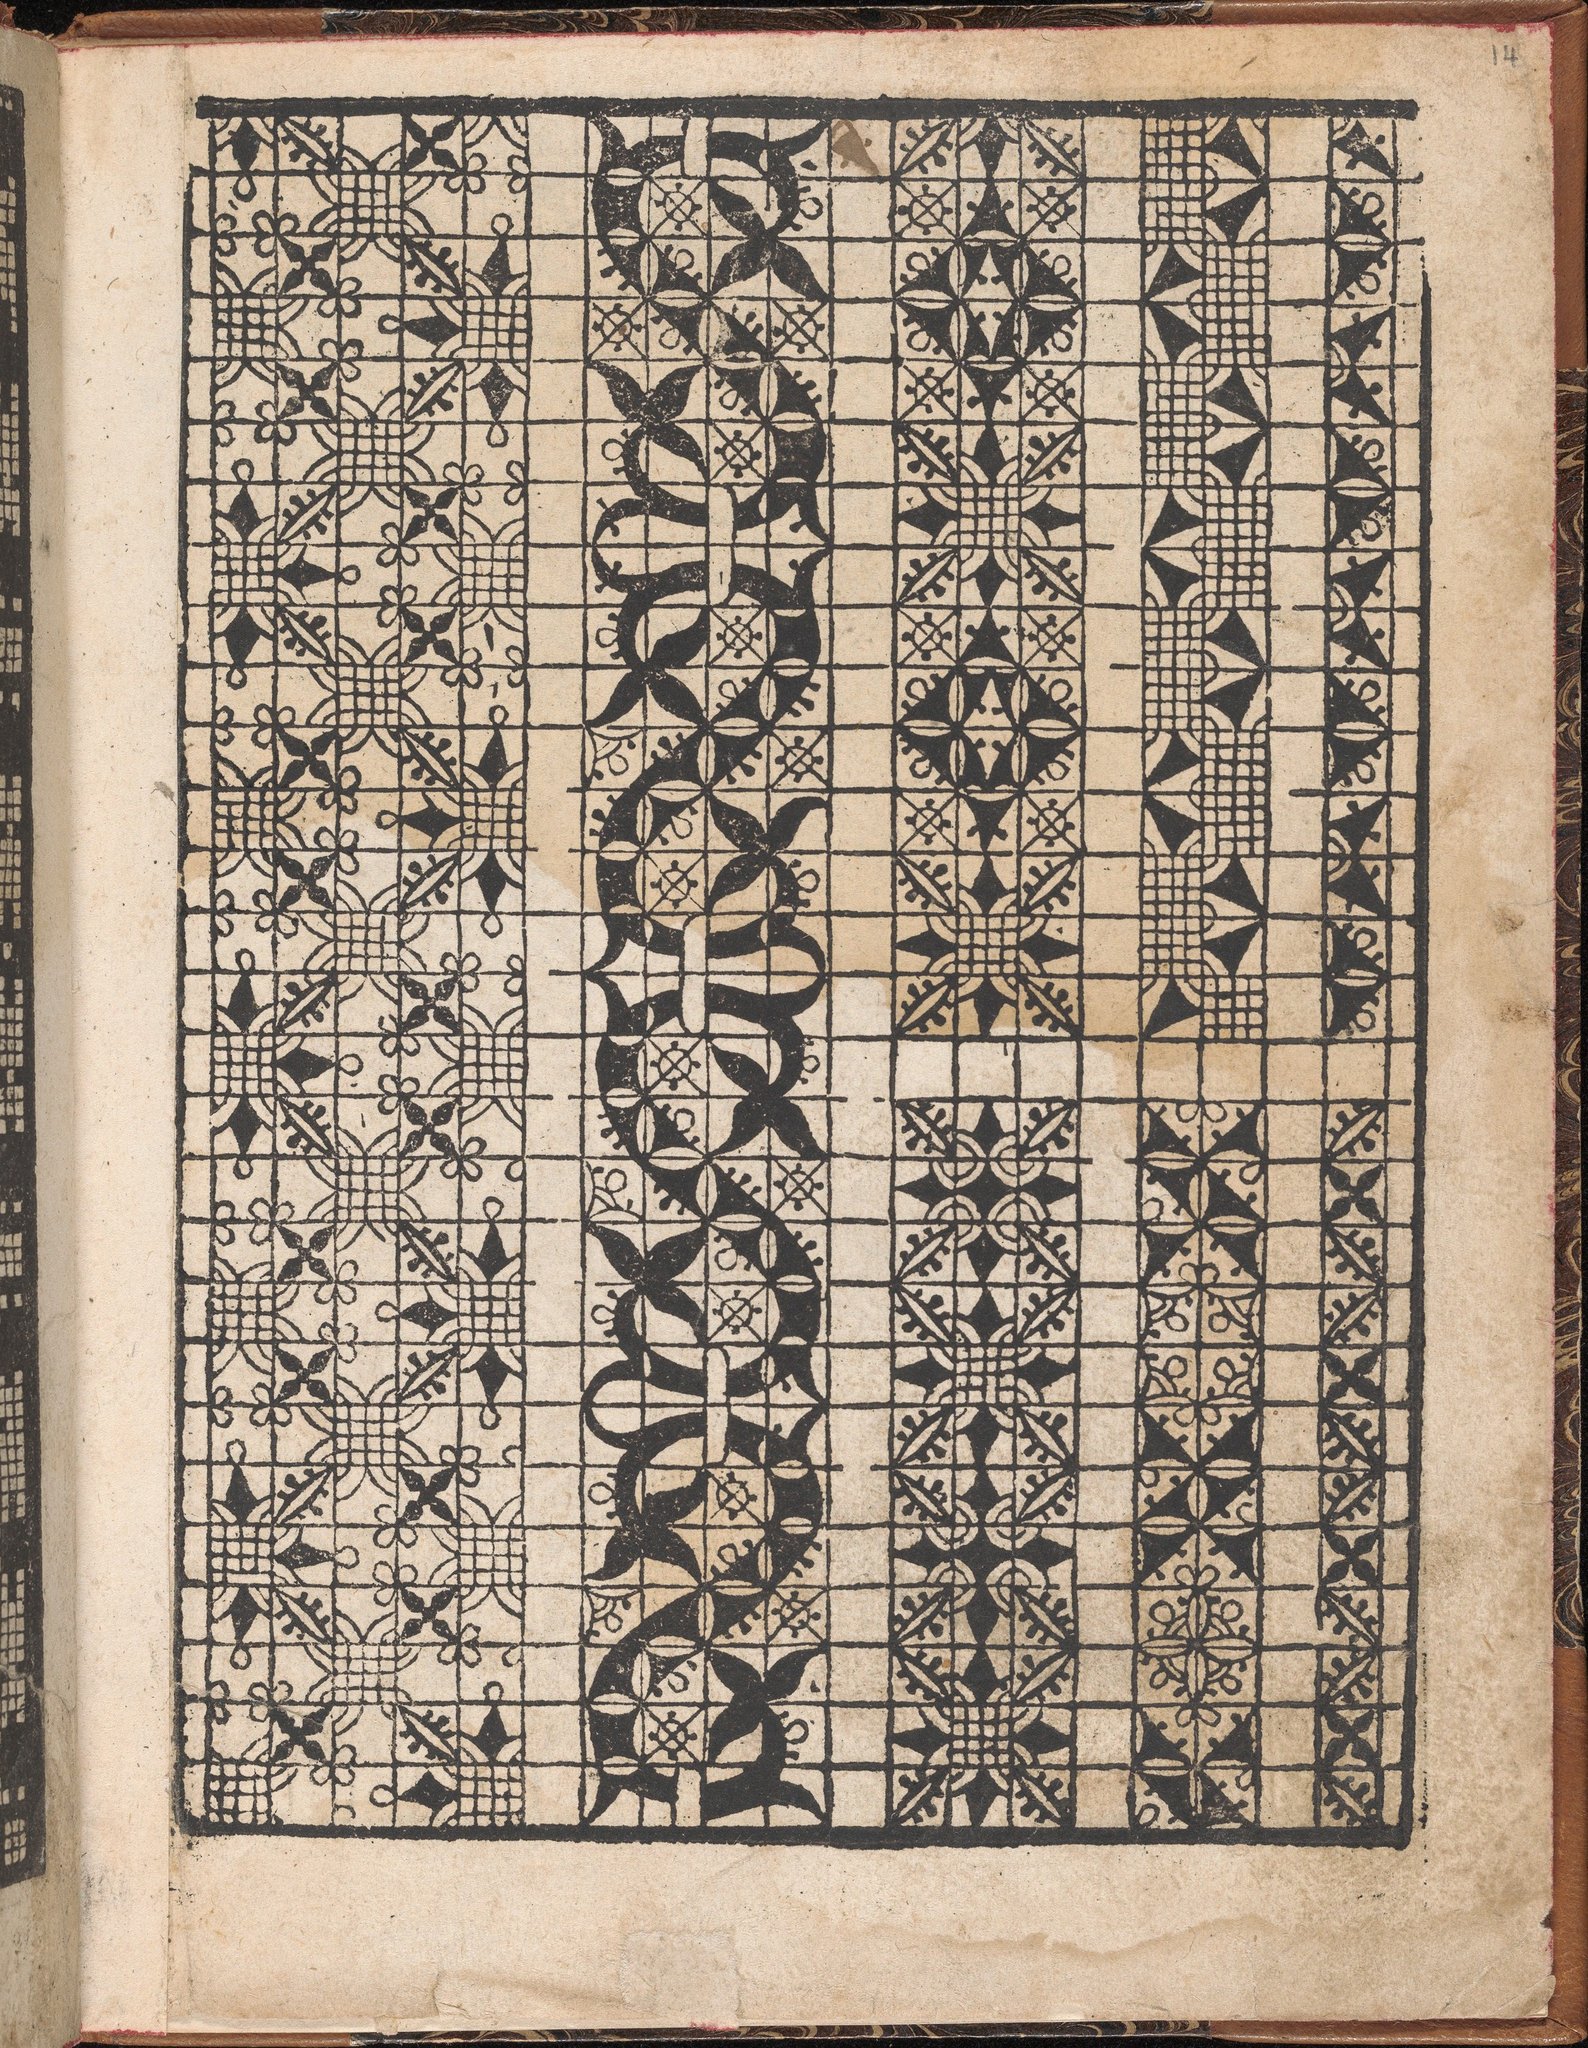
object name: book print ornament architecture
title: Spechio di pensieri delle belle et Virtudiose donne, page 14 (recto)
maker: matteo pagano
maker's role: publisher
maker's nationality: italian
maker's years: 1515-1588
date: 1546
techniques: woodcut